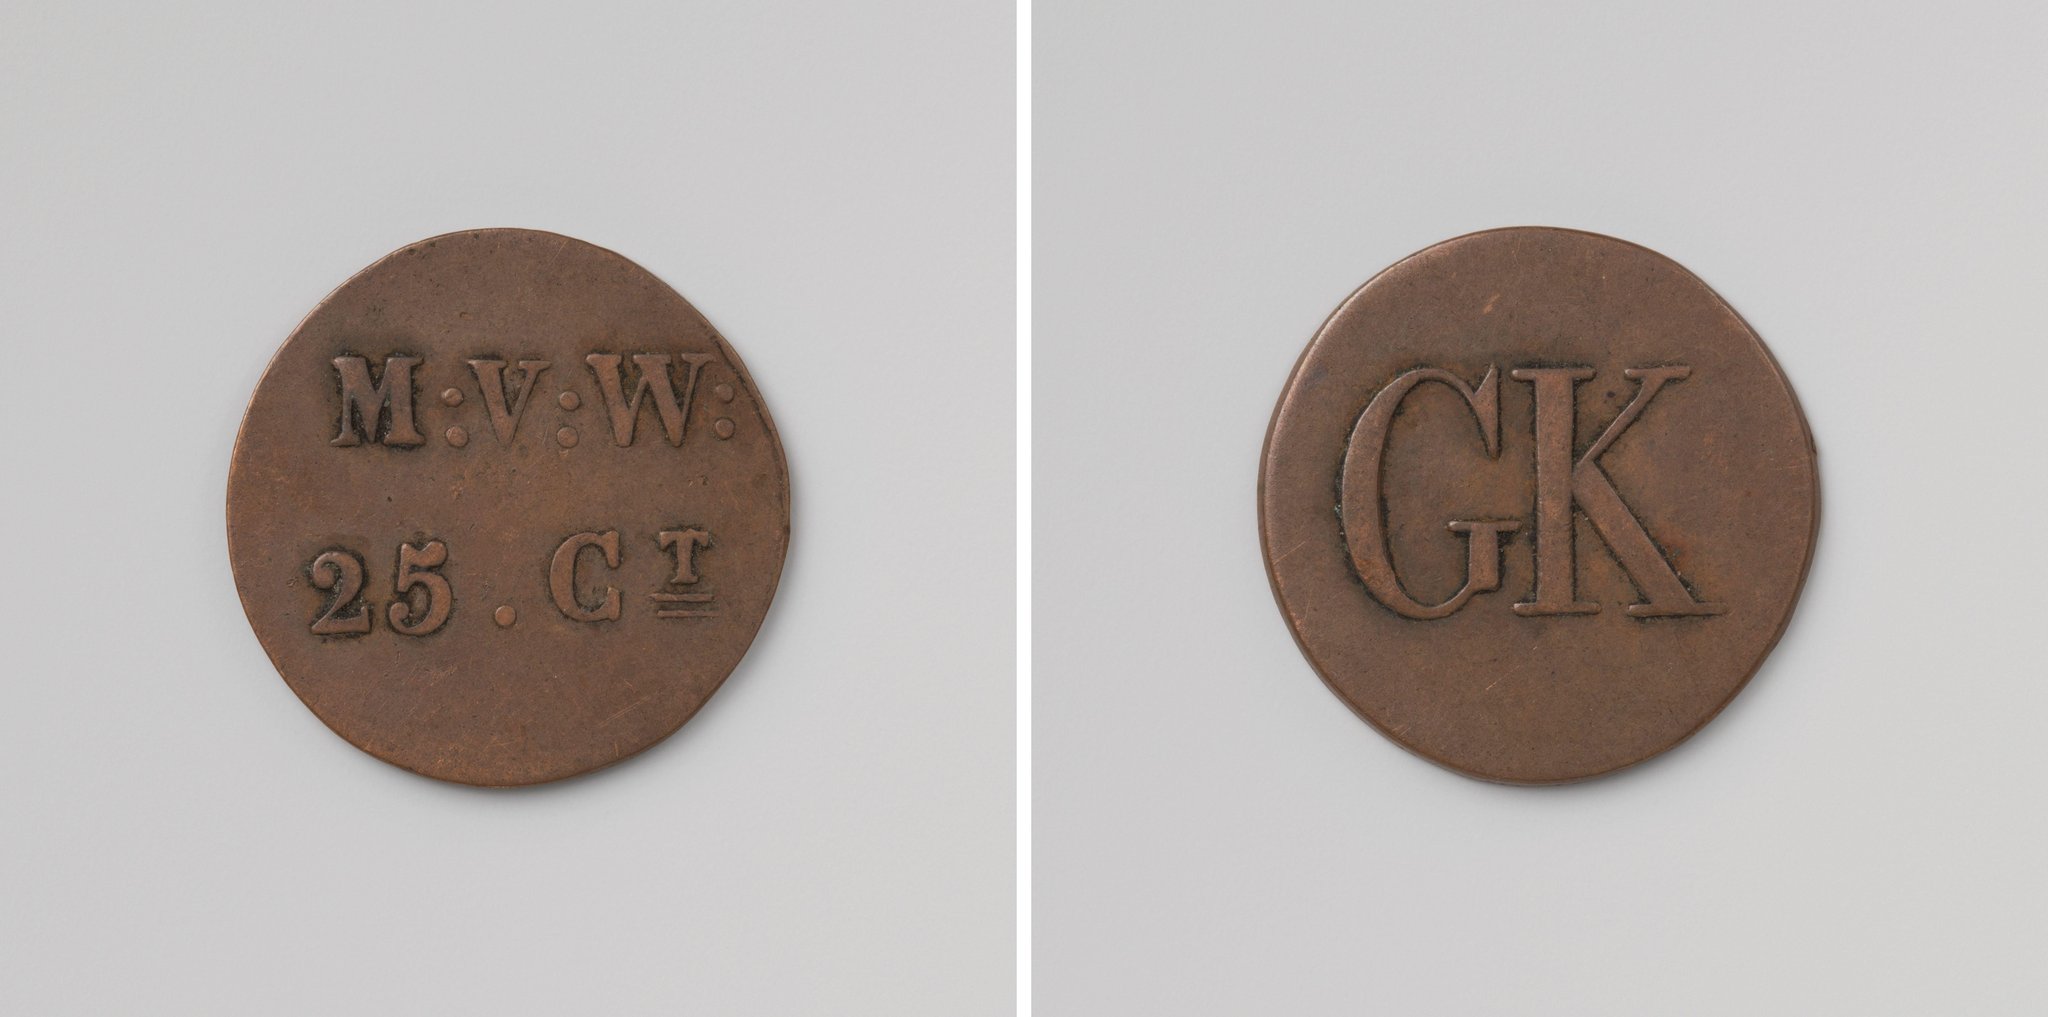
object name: huismunt prison money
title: Huismunt geslagen op last van de Maatschappij van Weldadigheid ter waarde van 25 cent, ten behoeve van de Gewone Koloniën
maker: Anonymous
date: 1818-1859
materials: copper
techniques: striking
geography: netherlands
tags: maatschappij van weldadigheid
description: Voorzijde: opschrift boven waardeaanduiding. Keerzijde: opschrift G en K